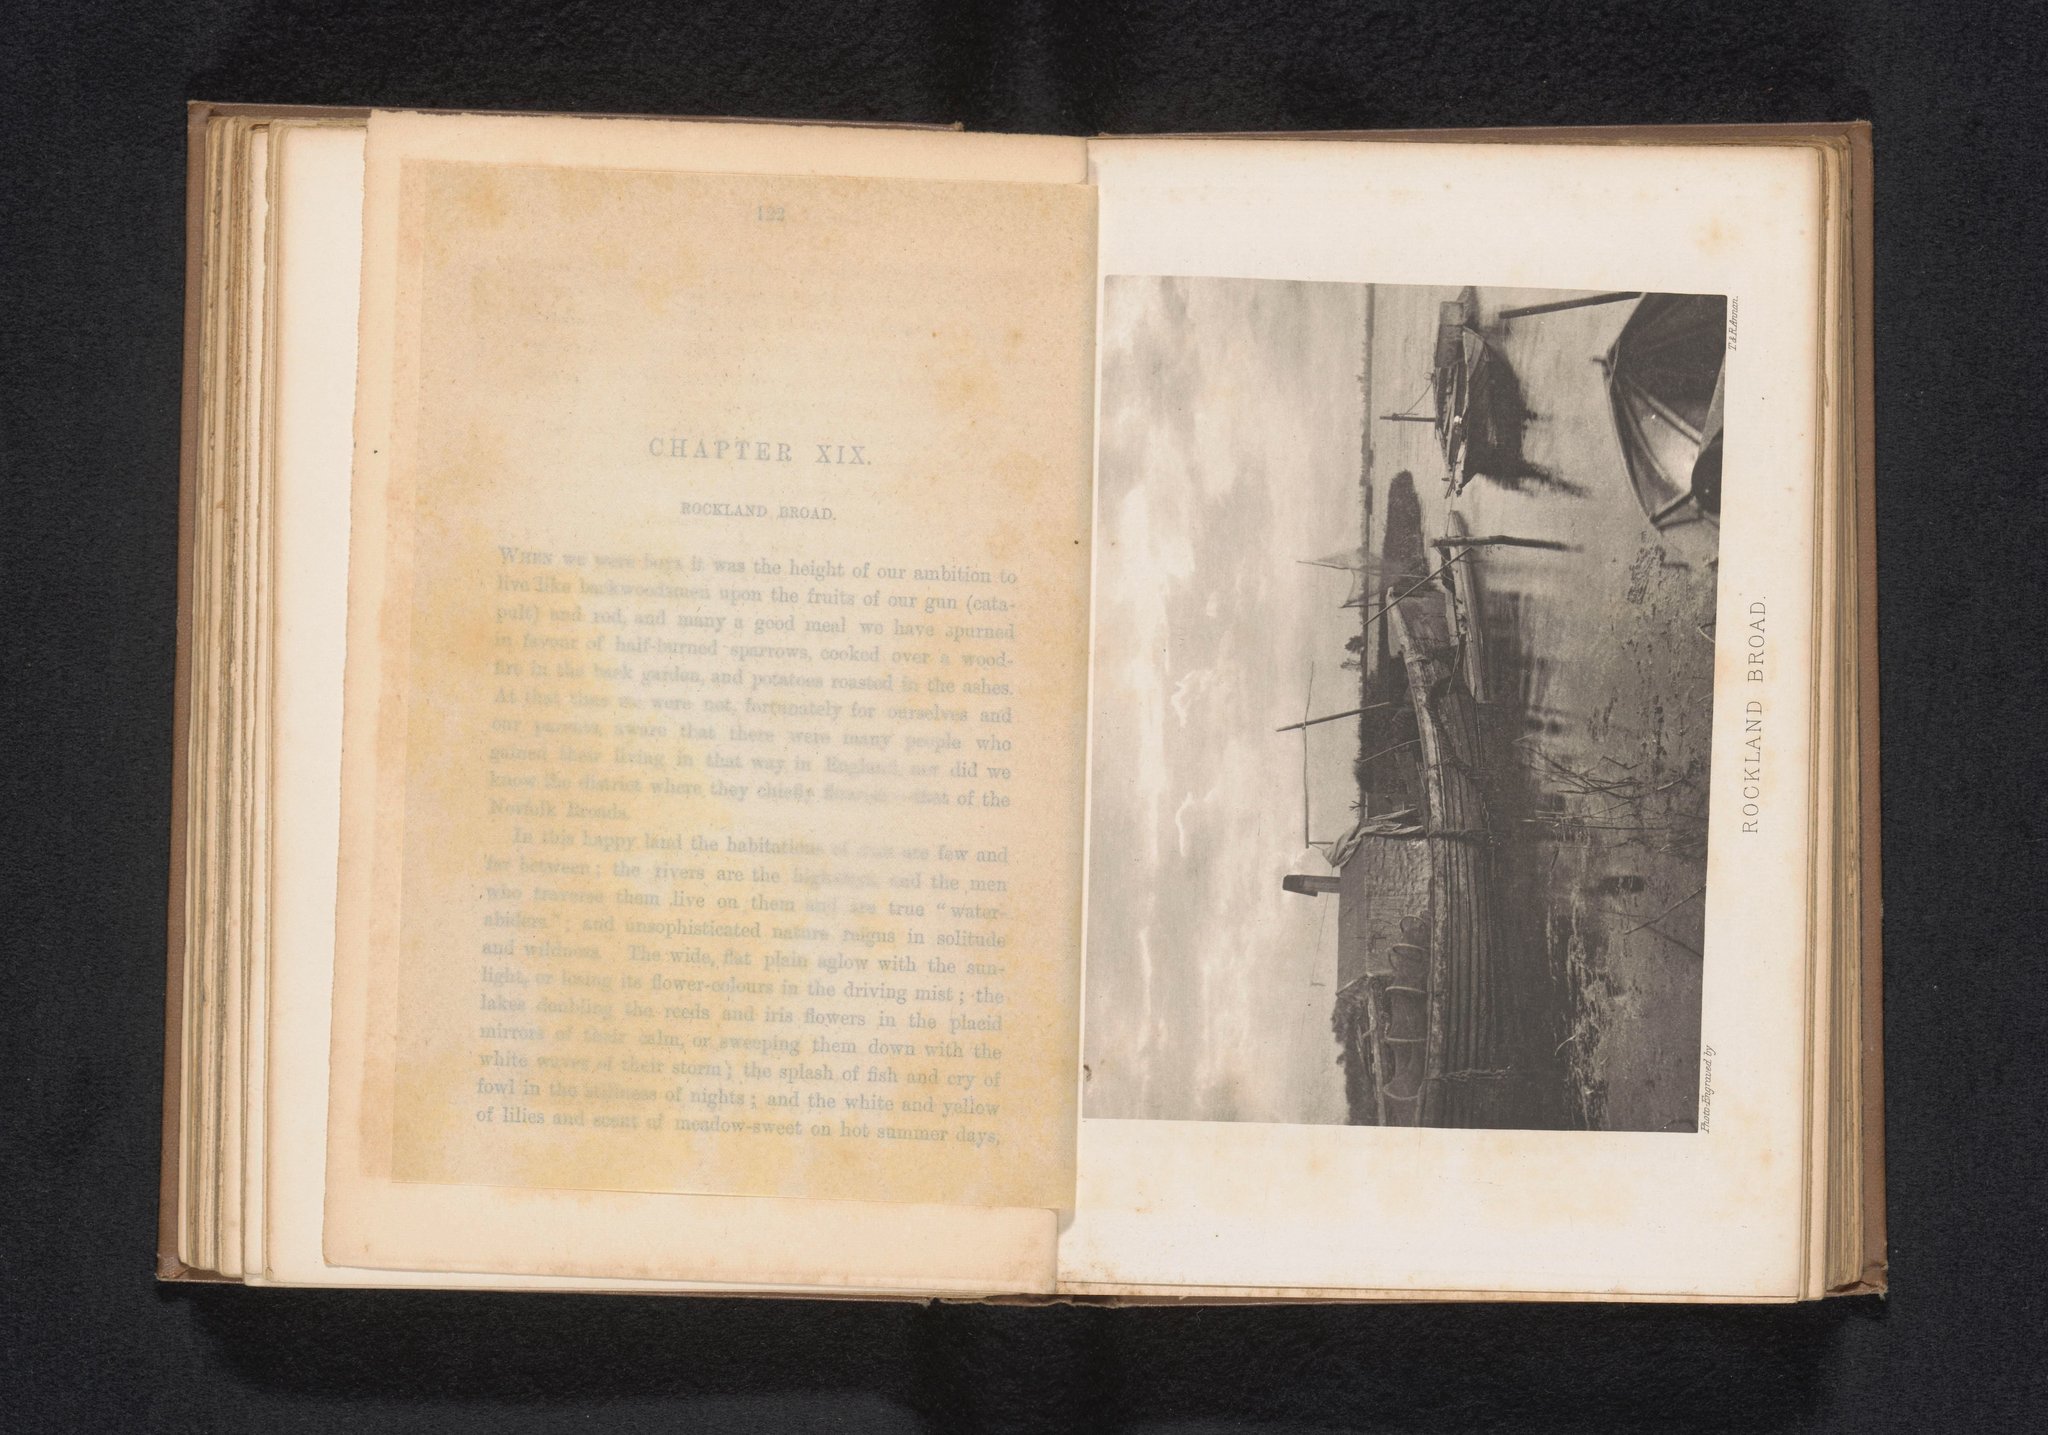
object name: photomechanical print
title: Gezicht op Rockland Broad nabij Rockland Saint Mary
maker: george christopher davies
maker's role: fotograaf, geoloog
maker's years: 1849-1922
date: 1878-1883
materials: paper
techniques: photoaquatint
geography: rockland saint mary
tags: rowing-boat, canoe, etc., lake